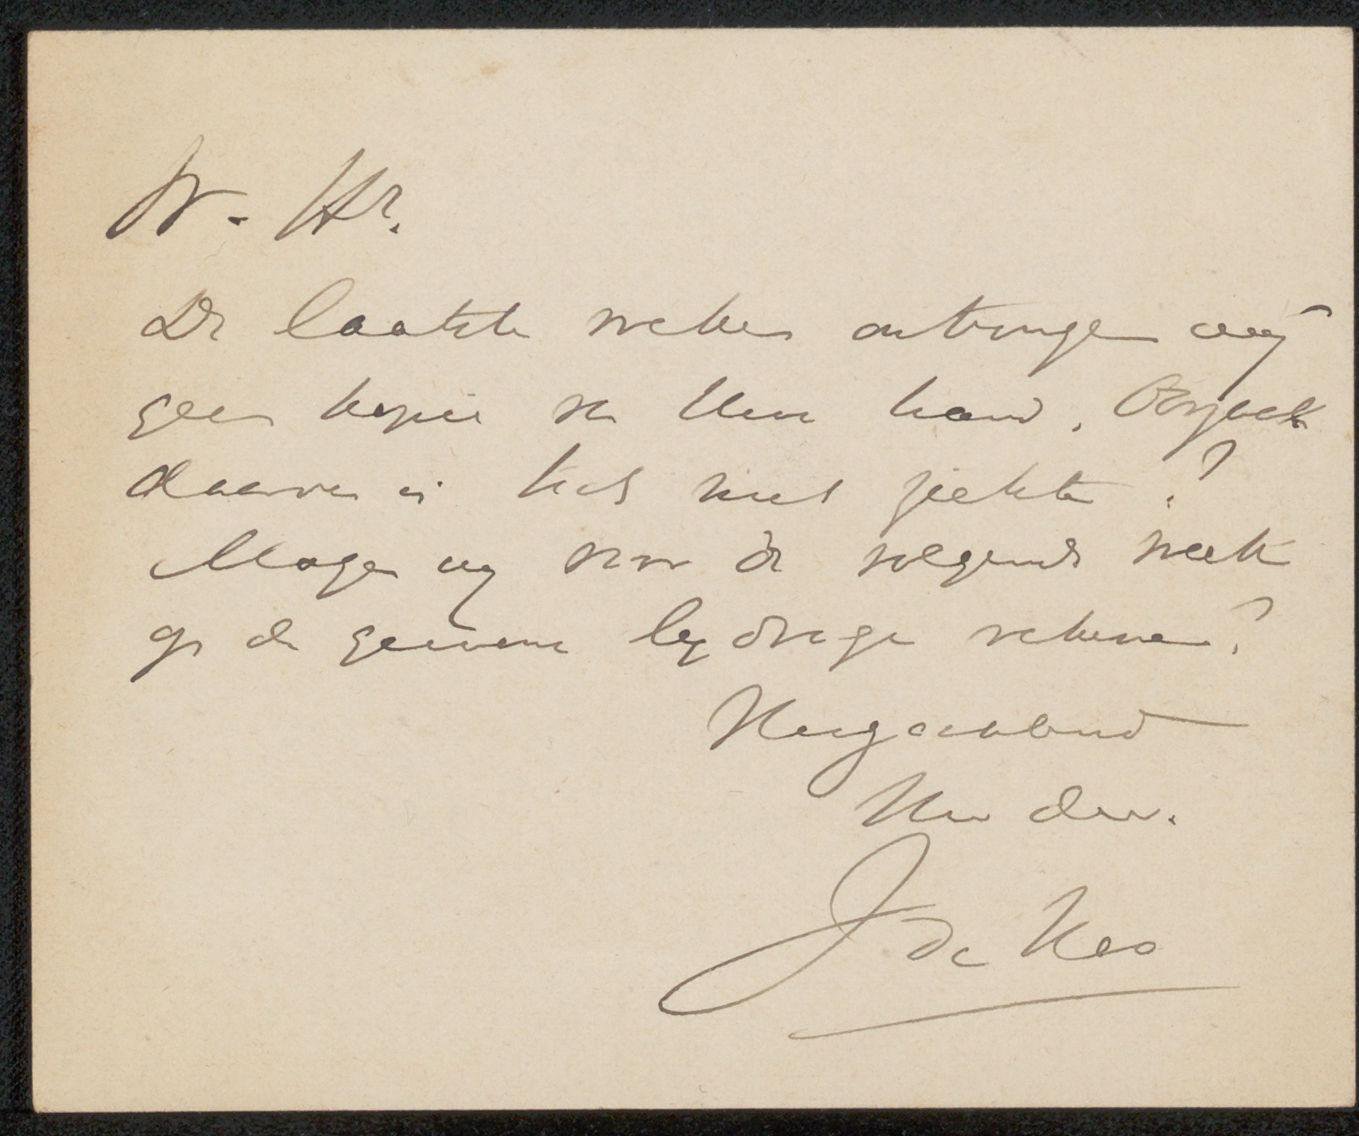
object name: letter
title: Brief aan Philip Zilcken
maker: johannes de koo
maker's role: auteur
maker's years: 1841-1909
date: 1851-1909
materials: cardboard, ink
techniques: pen, writing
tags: the hague, painter, philip zilcken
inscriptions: collector's mark: ‘RPK’